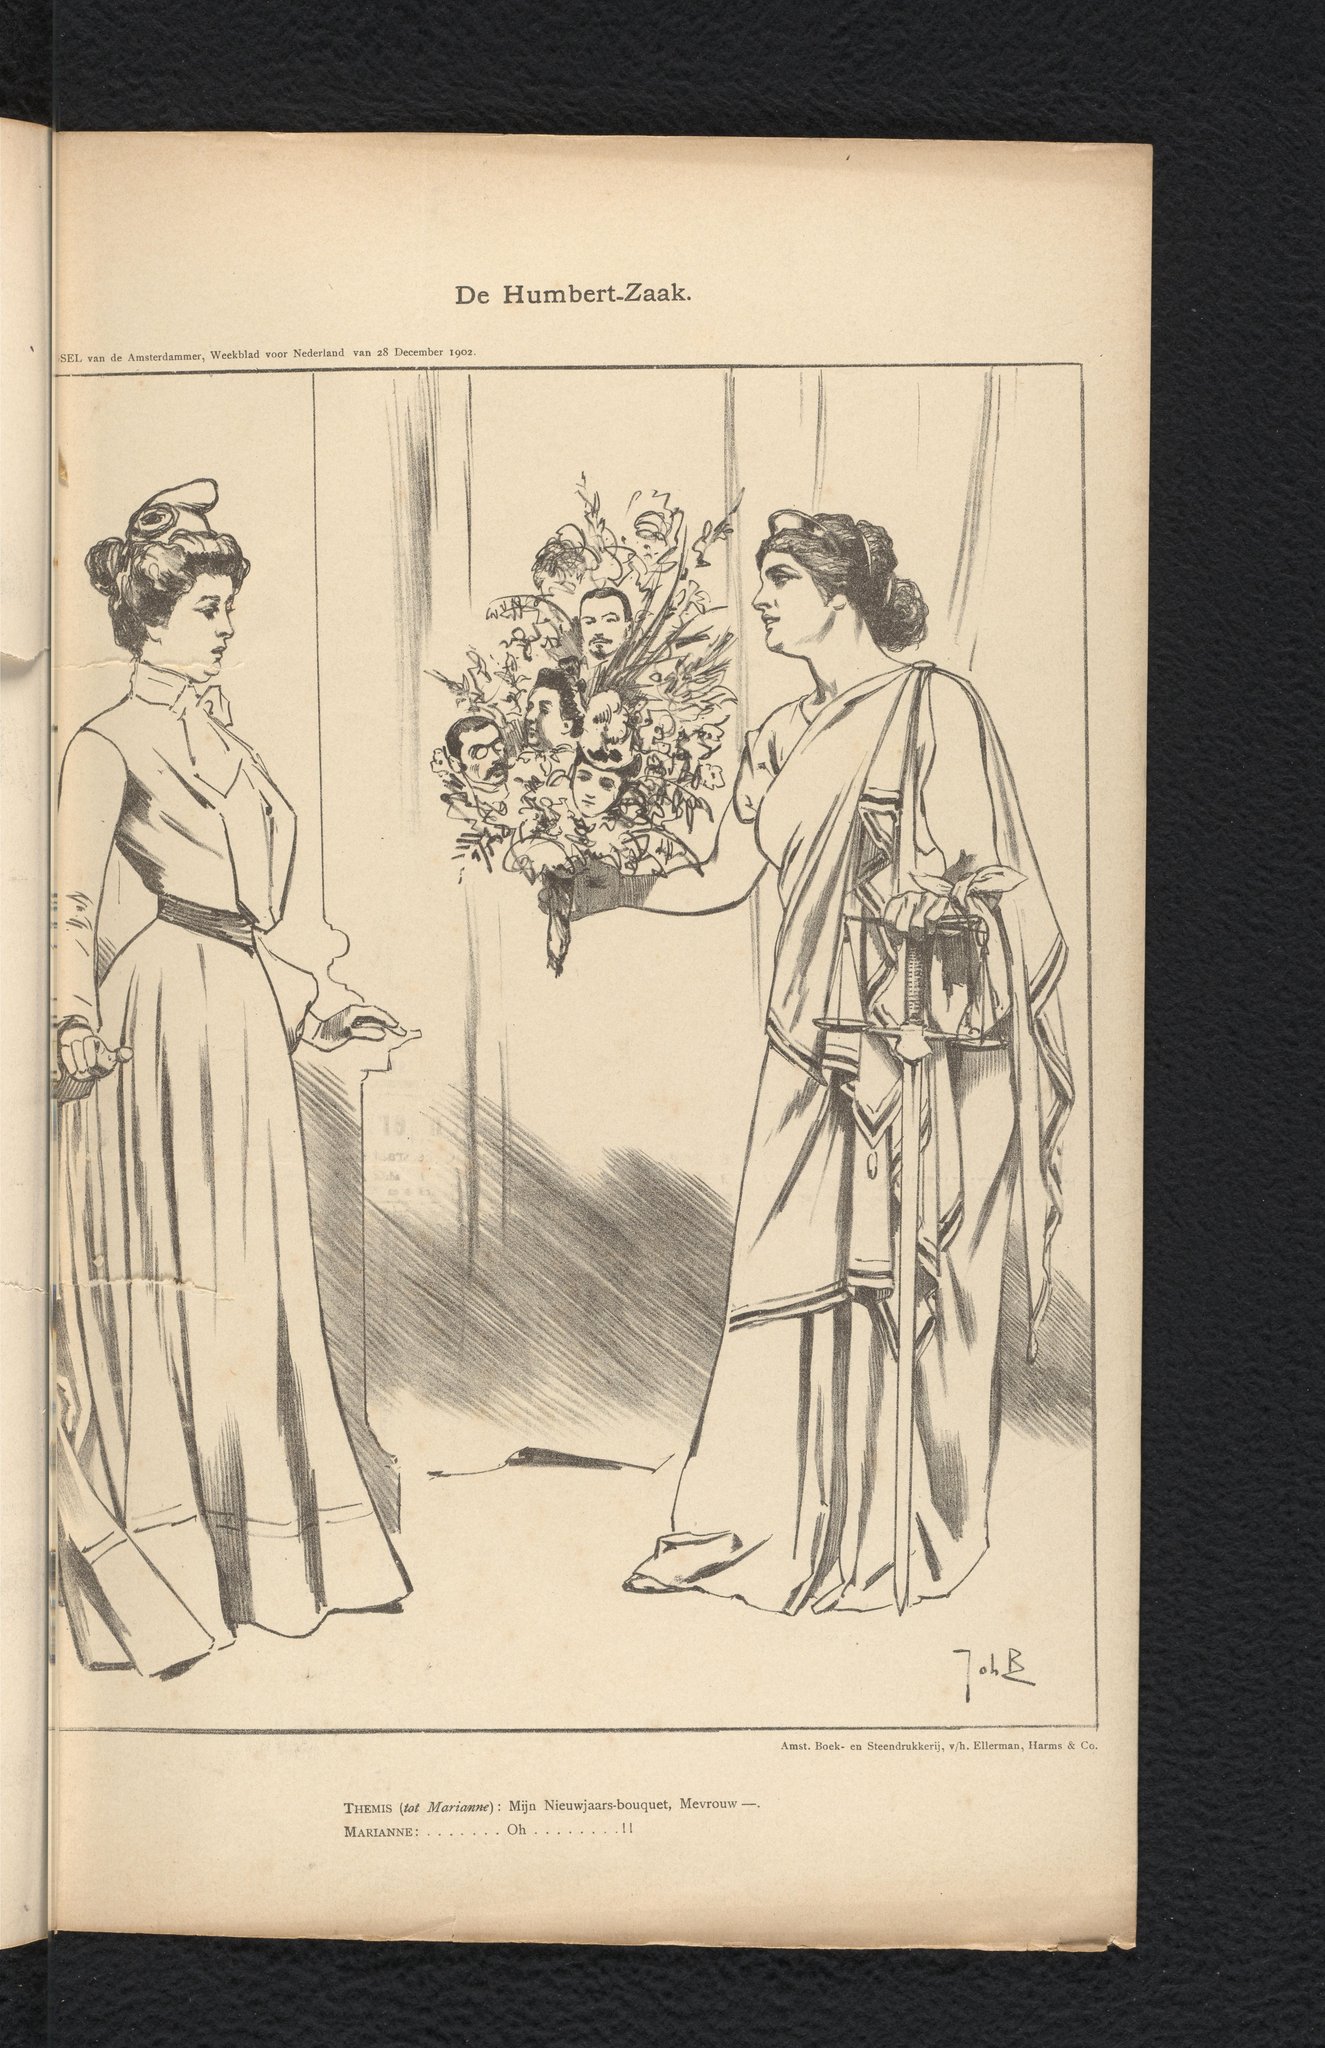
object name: cartoon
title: De Humbert-Zaak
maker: johan braakensiek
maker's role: draughtsman, print maker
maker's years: 1858-1940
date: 1902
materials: paper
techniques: lithograph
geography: amsterdam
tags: justice, 'justitia'; 'giustitia divina' (ripa) ~ one of the four cardinal virtues, personifications of countries, nations, states, districts, etc., political caricatures and satires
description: Justitia overhandigt aan Marianne (Frankrijk) een boeket met bloemen met de hoofdschuldigen in de zogenaamde Humbert-affaire. De oplichtster Thérèse Humbert werd in december in Madrid gearresteerd en in Frankrijk met haar familieleden veroordeeld.